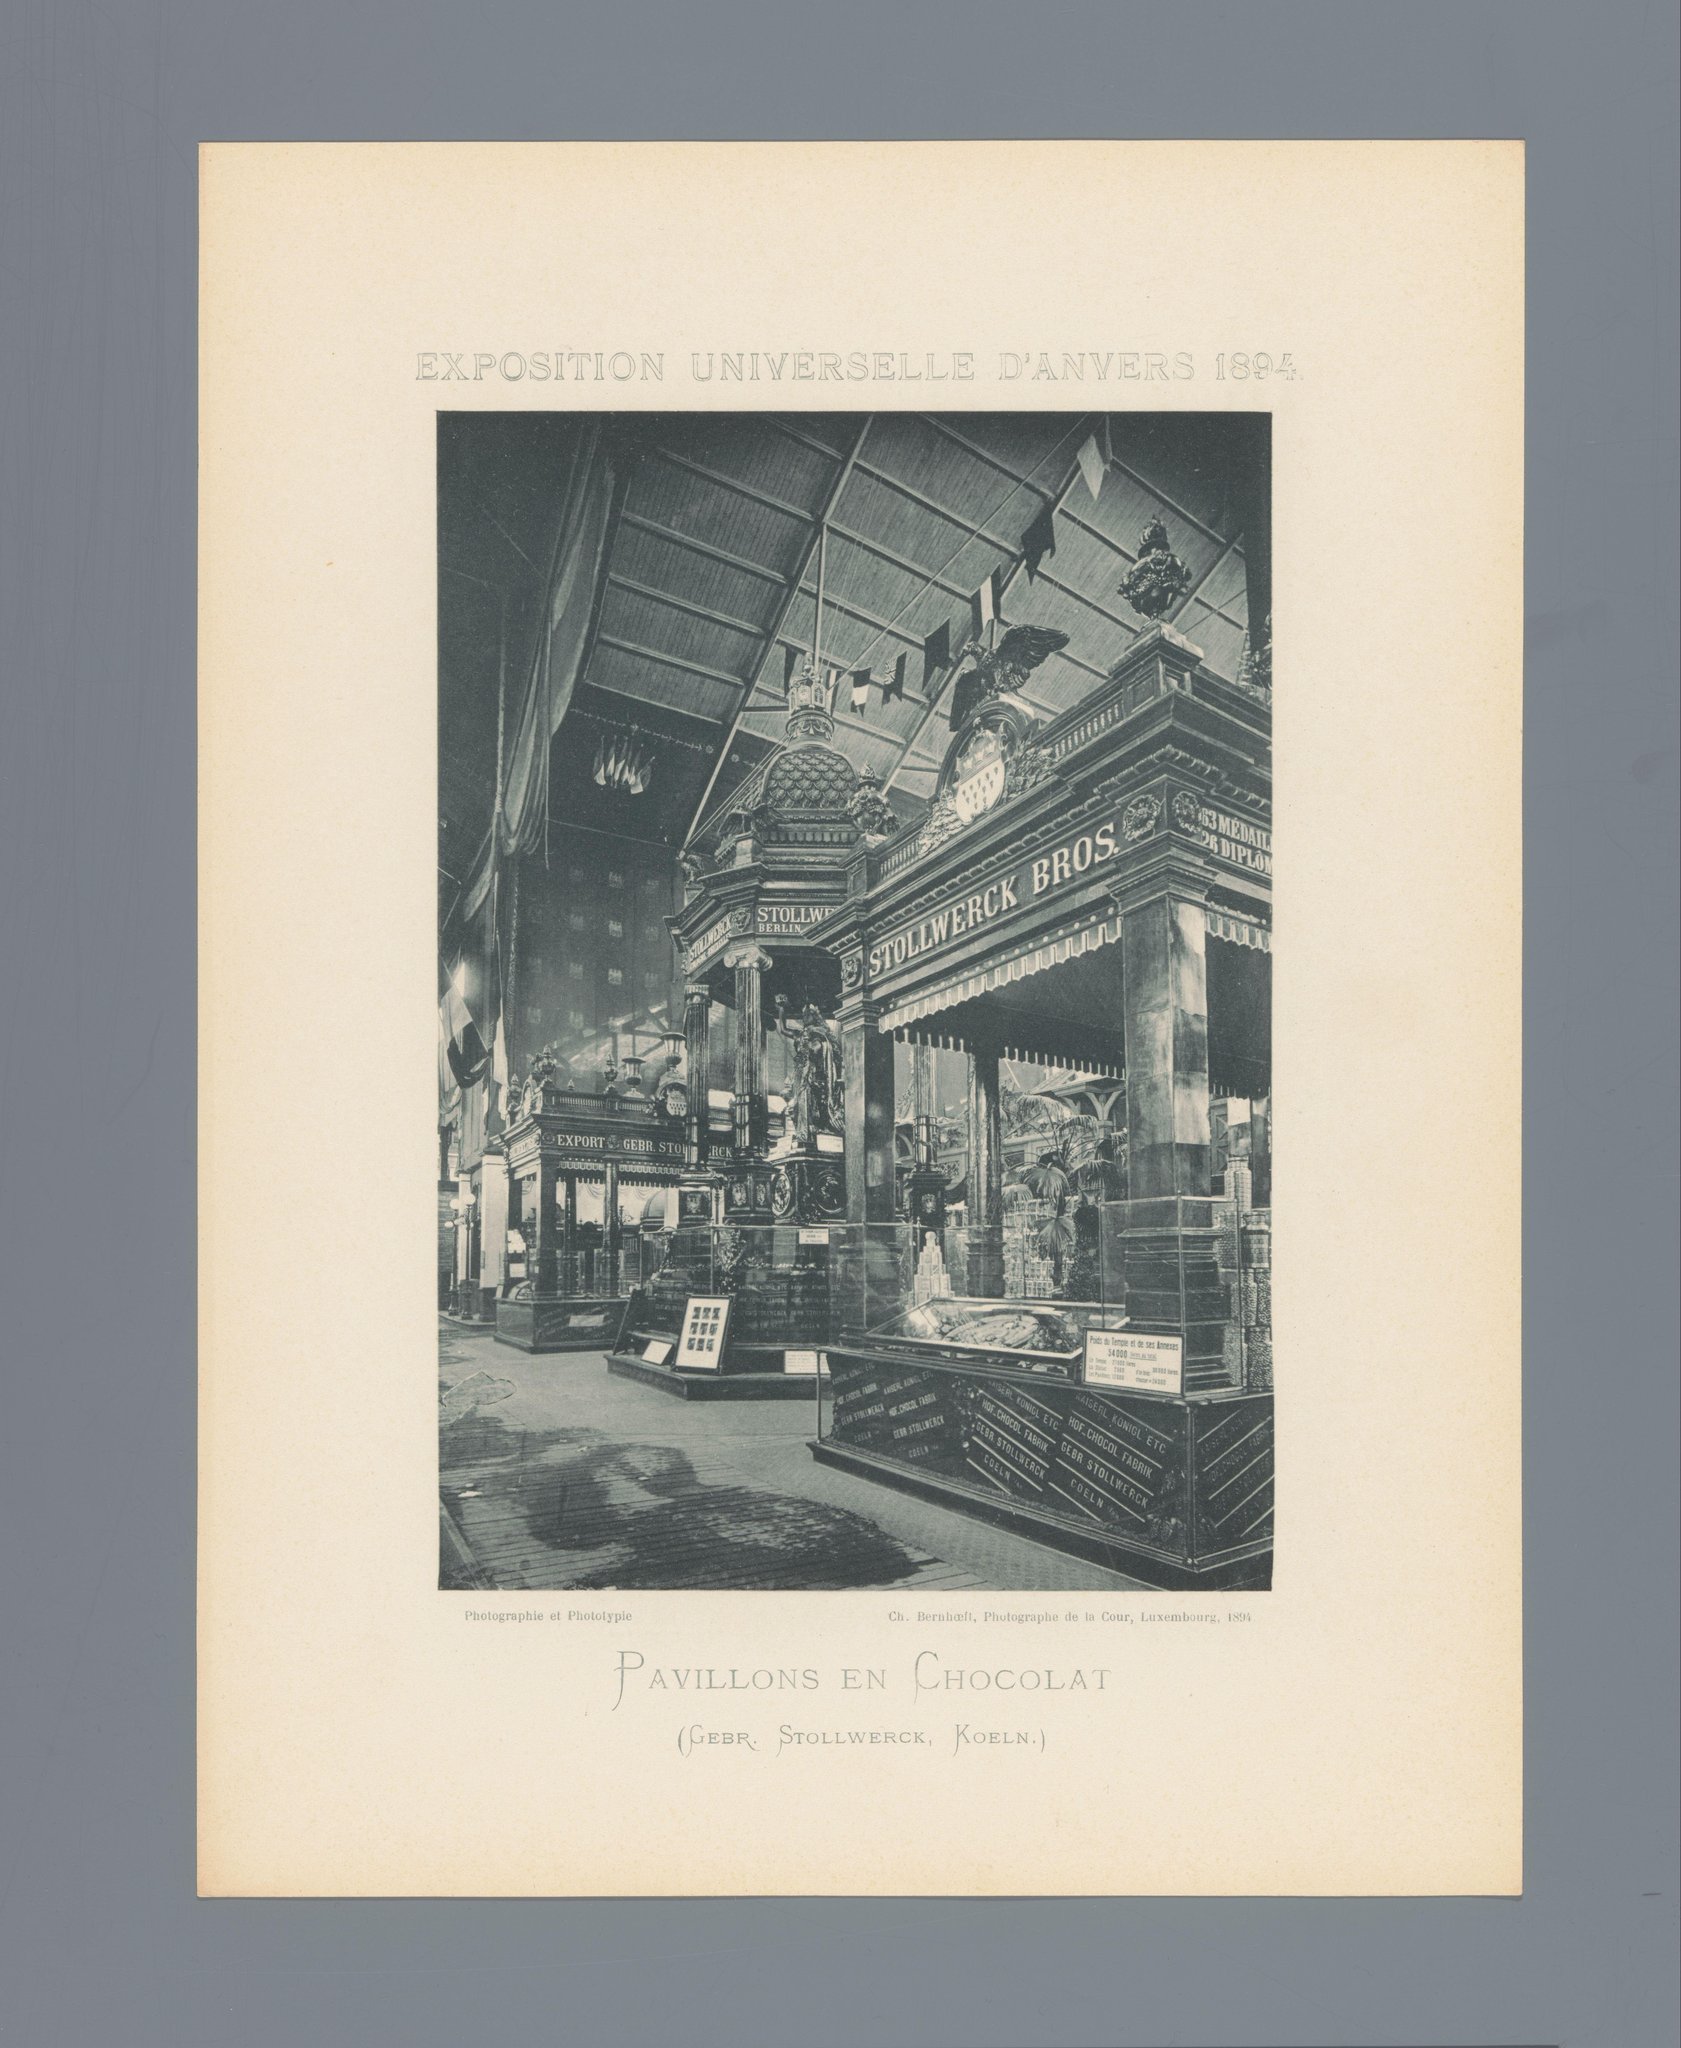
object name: photomechanical print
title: Pavillons en Chocolat (Gebr. Stollwerck, Koeln)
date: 1894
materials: paper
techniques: photograph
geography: antwerp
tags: world fair, world exhibition, stall, booth (~ market), antwerp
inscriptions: inscription: ‘Exposition Universelle D'Anvers 1894’